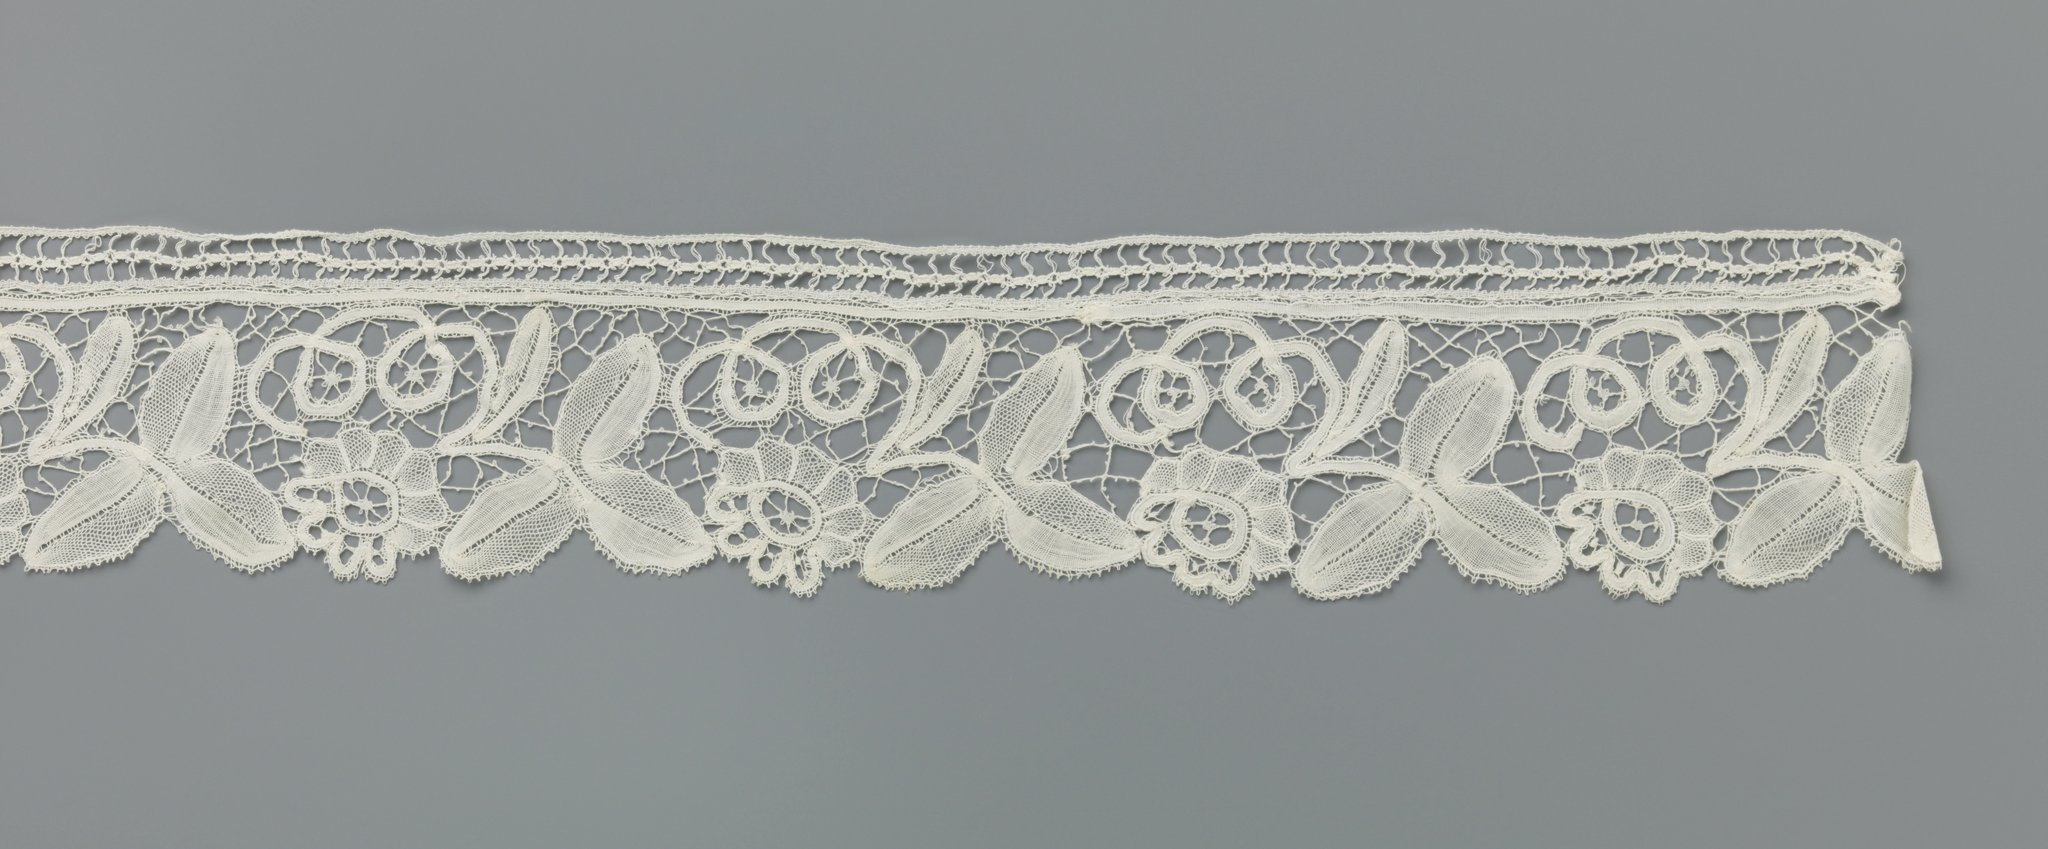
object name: strip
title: Strook kloskant met grof drieblad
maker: Anonymous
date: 1875-1899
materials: cotton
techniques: lace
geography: netherlands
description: Strook naturelkleurige kloskant: duchesse-kant. Op een zeer open vlechtengrond staan eenzijdig gerichte serpentine-takken met een anemoon en een groot drieblad, die afwisselend de ongelijke schulpen vormen.